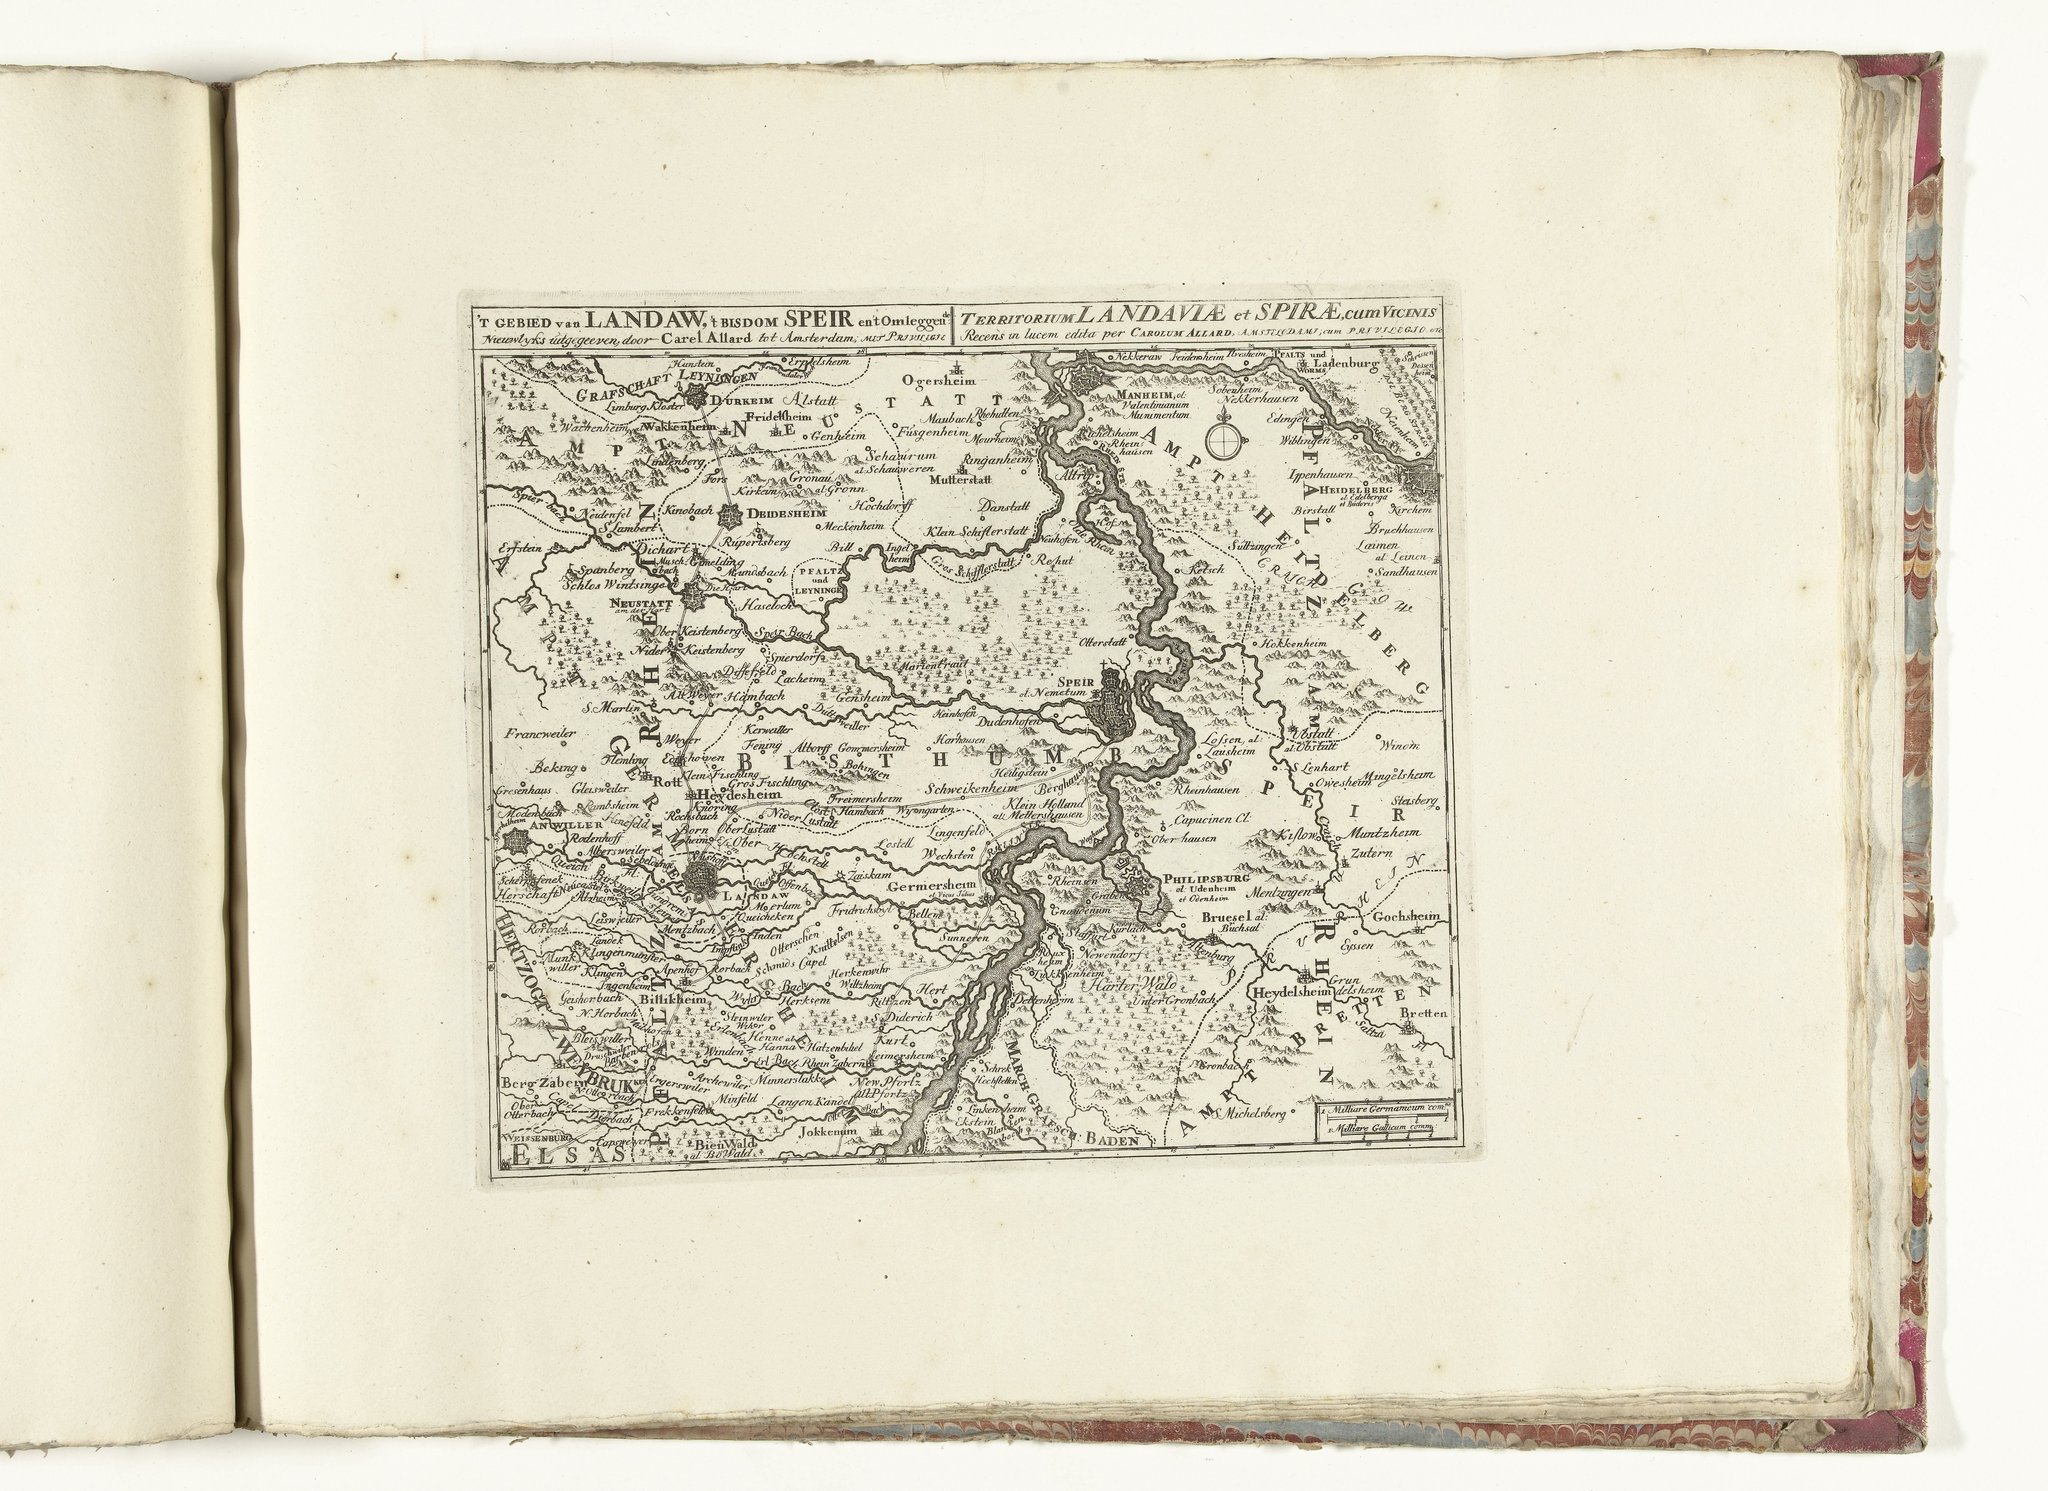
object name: print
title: Les Principales Forteresses & Villes Fortes, d'Espagne, de France, d'Italie, de Savoië, d'Allemagne & des Païs-Bas (...) / Naaukeurige Afbeeldingen der Voornaamste Sterke Steden en Vestingen in Spanjen, Vrankryk, Italien, Savoyen, Duytsland en Nederlanden (...)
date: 1701-1714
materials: paper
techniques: etching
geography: amsterdam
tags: maps of separate countries or regions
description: Gekopieerd naar de Franse prenten in: Nicolas de Fer, Les forces de l'Europe, ou description des principales villes, avec leurs fortifications : dessignées par les meilleurs ingenieurs, particulierement celles ... de la France, dont les plans ont esté levez par M. de Vauban, Nicolas de Fer, Parijs 1693-1696, of andere voorbeelden.